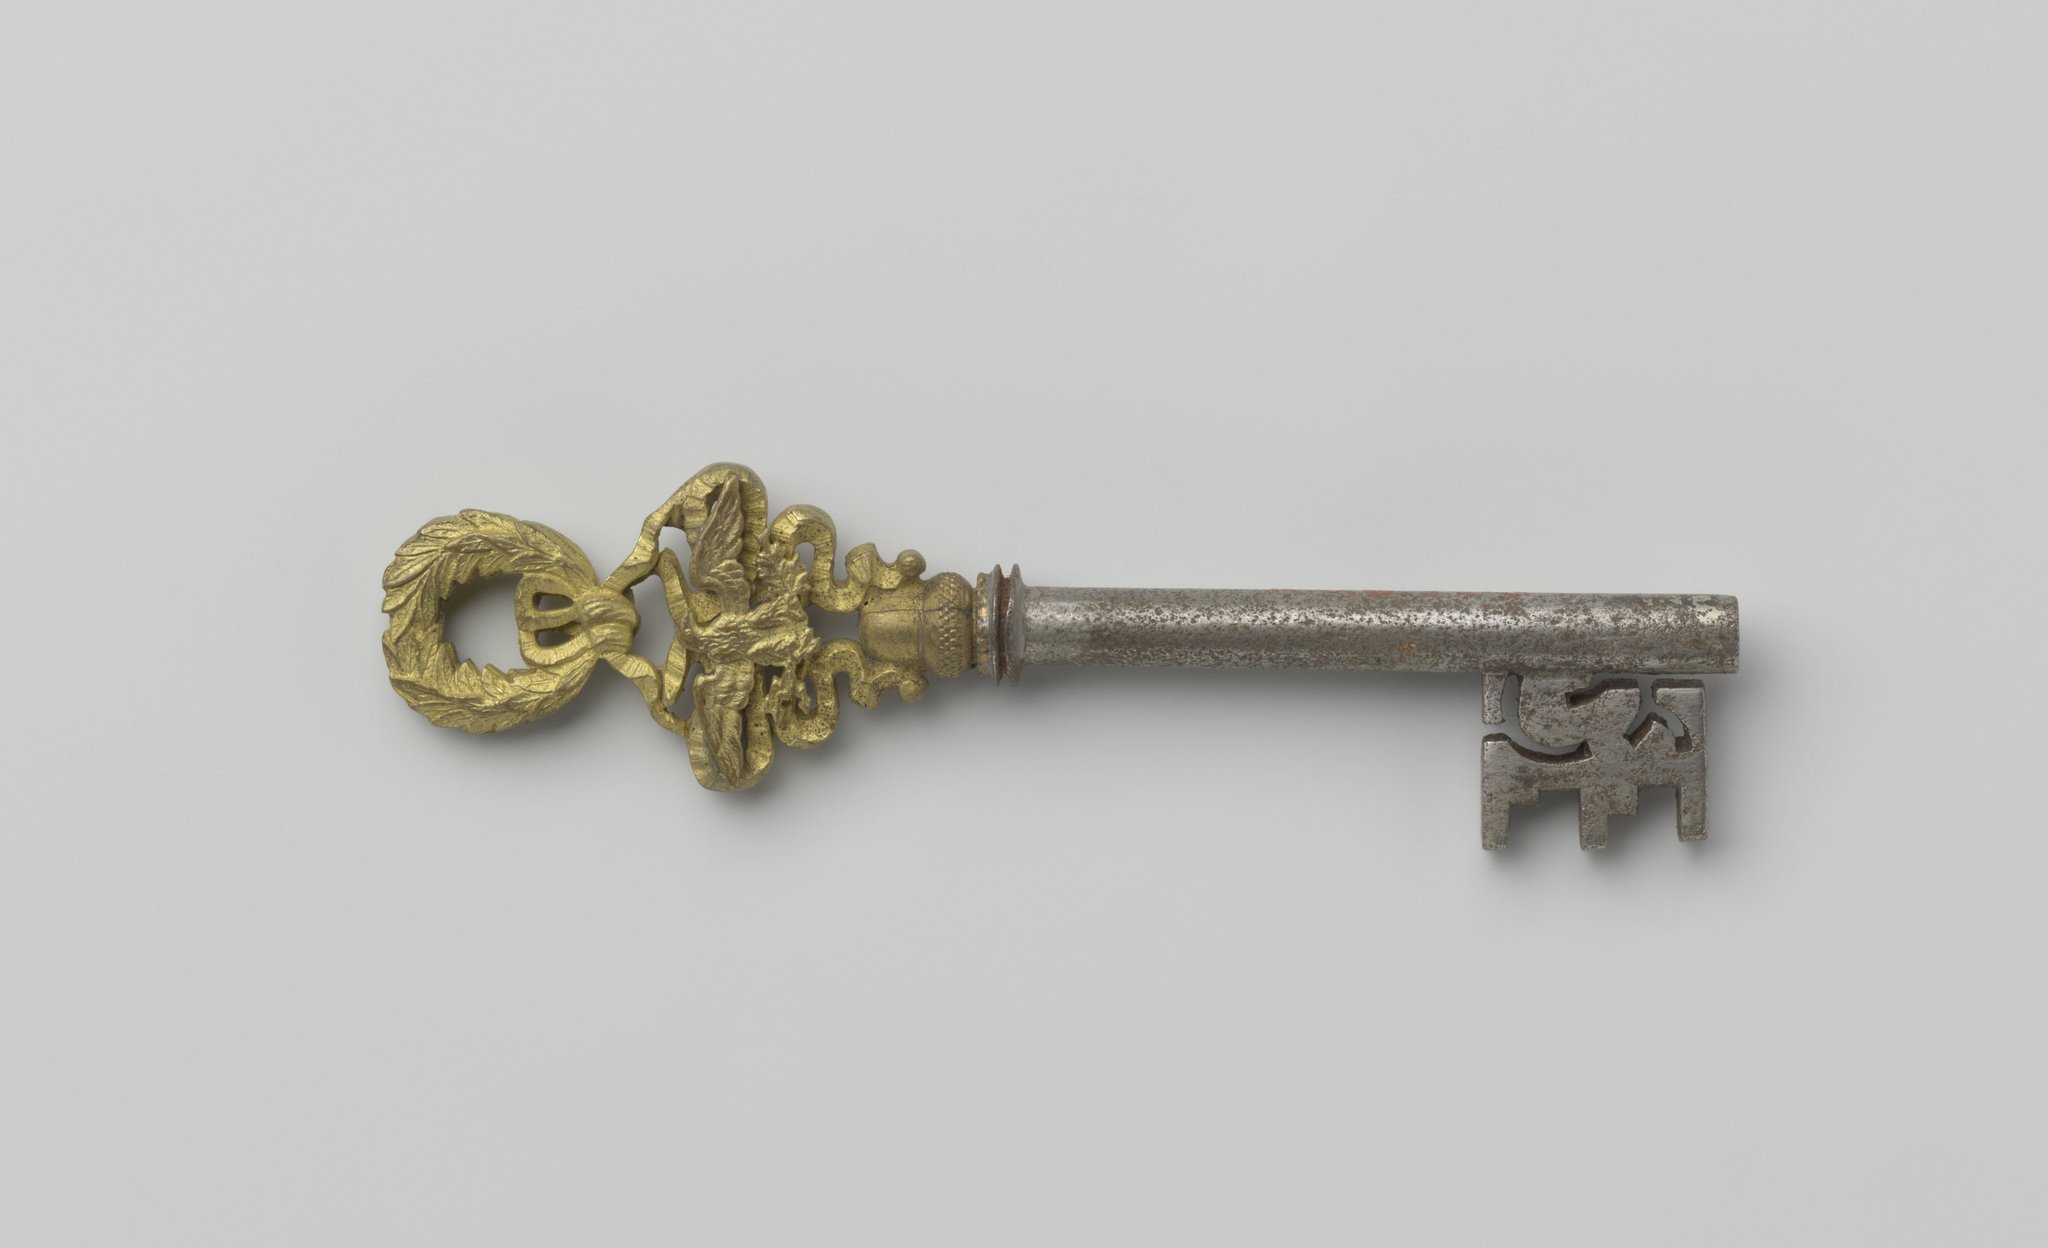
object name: pipe key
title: Pijpsleutel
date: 1800-1900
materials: copper, iron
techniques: gilding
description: Pijpsleutel met greep bestaande uit een lauwerkrans waaraan een lint gestrikt is en waarvan de uiteinden zig-zagsgewijs van beneden hangen tegen een cirkelvormig kapiteel. Aan een zijde van de greep is een adelaar bevestigd. Greep en kapiteel van verguld koper, schacht en baard van ijzer.